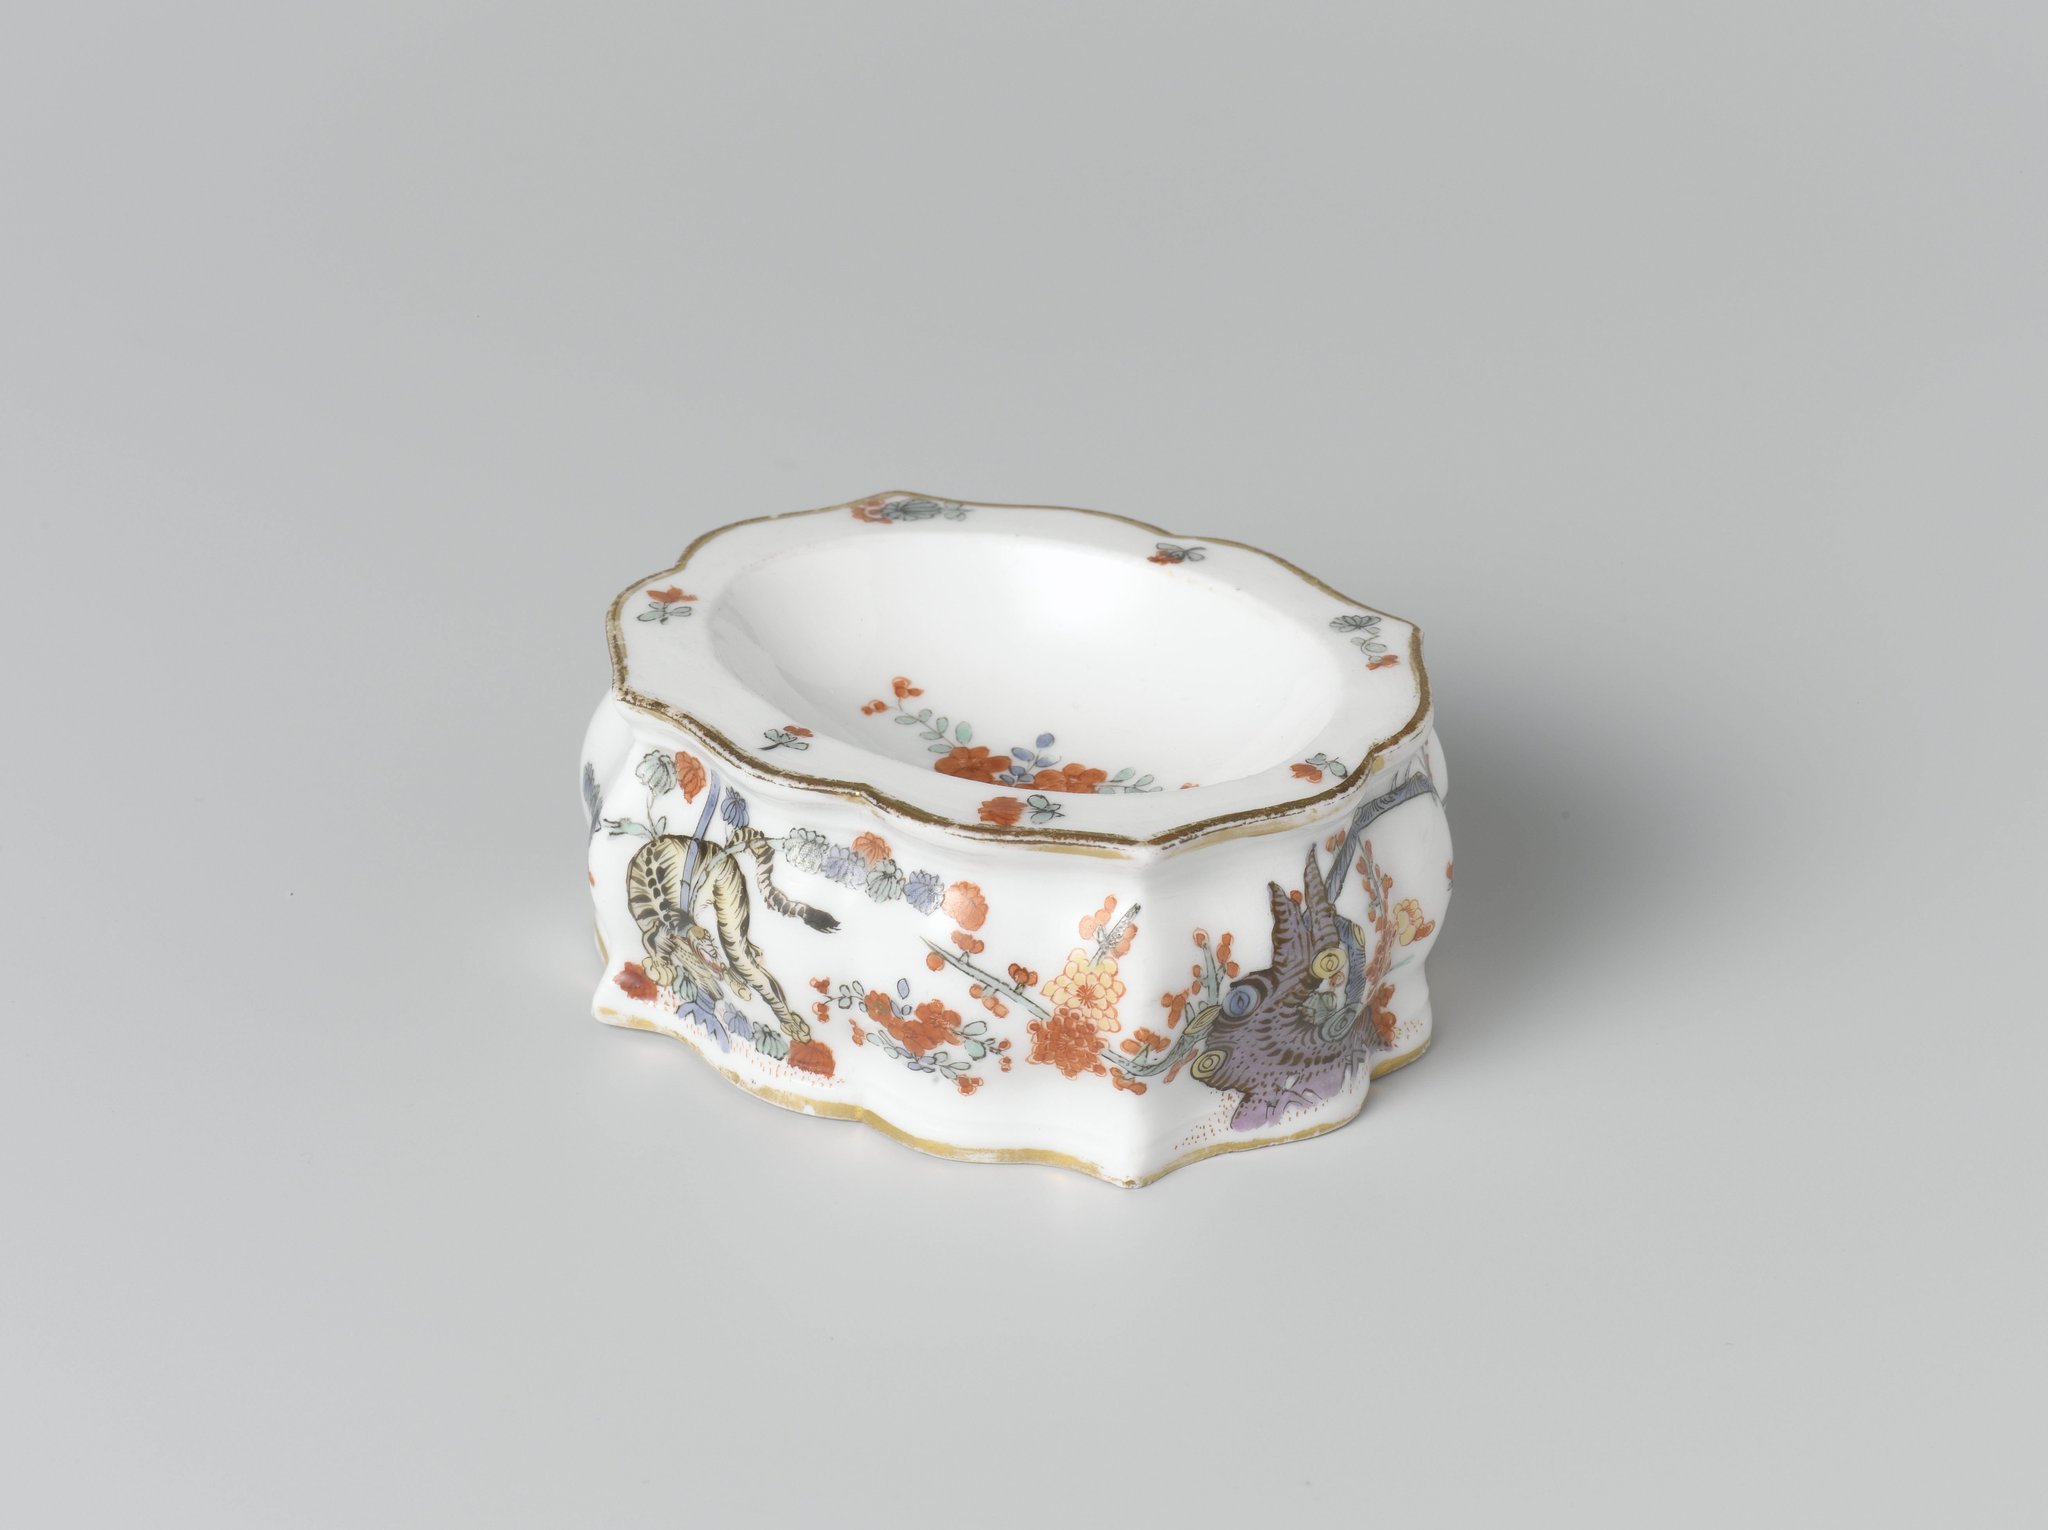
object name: salt condiment vessel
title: Zoutvat, veelkleurig beschilderd met een Kakiemon-decor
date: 1740-1745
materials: porcelain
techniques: painted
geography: meissen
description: Zoutvat van beschilderd porselein. Het zoutvat is rechthoekig en heeft accoladevormige gewelfde wanden. Het zoutvat is versierd met een boomstronk in violet, waaraan takken met bloemen in kakiemon-stijl en met een tijger om een bamboestengel.